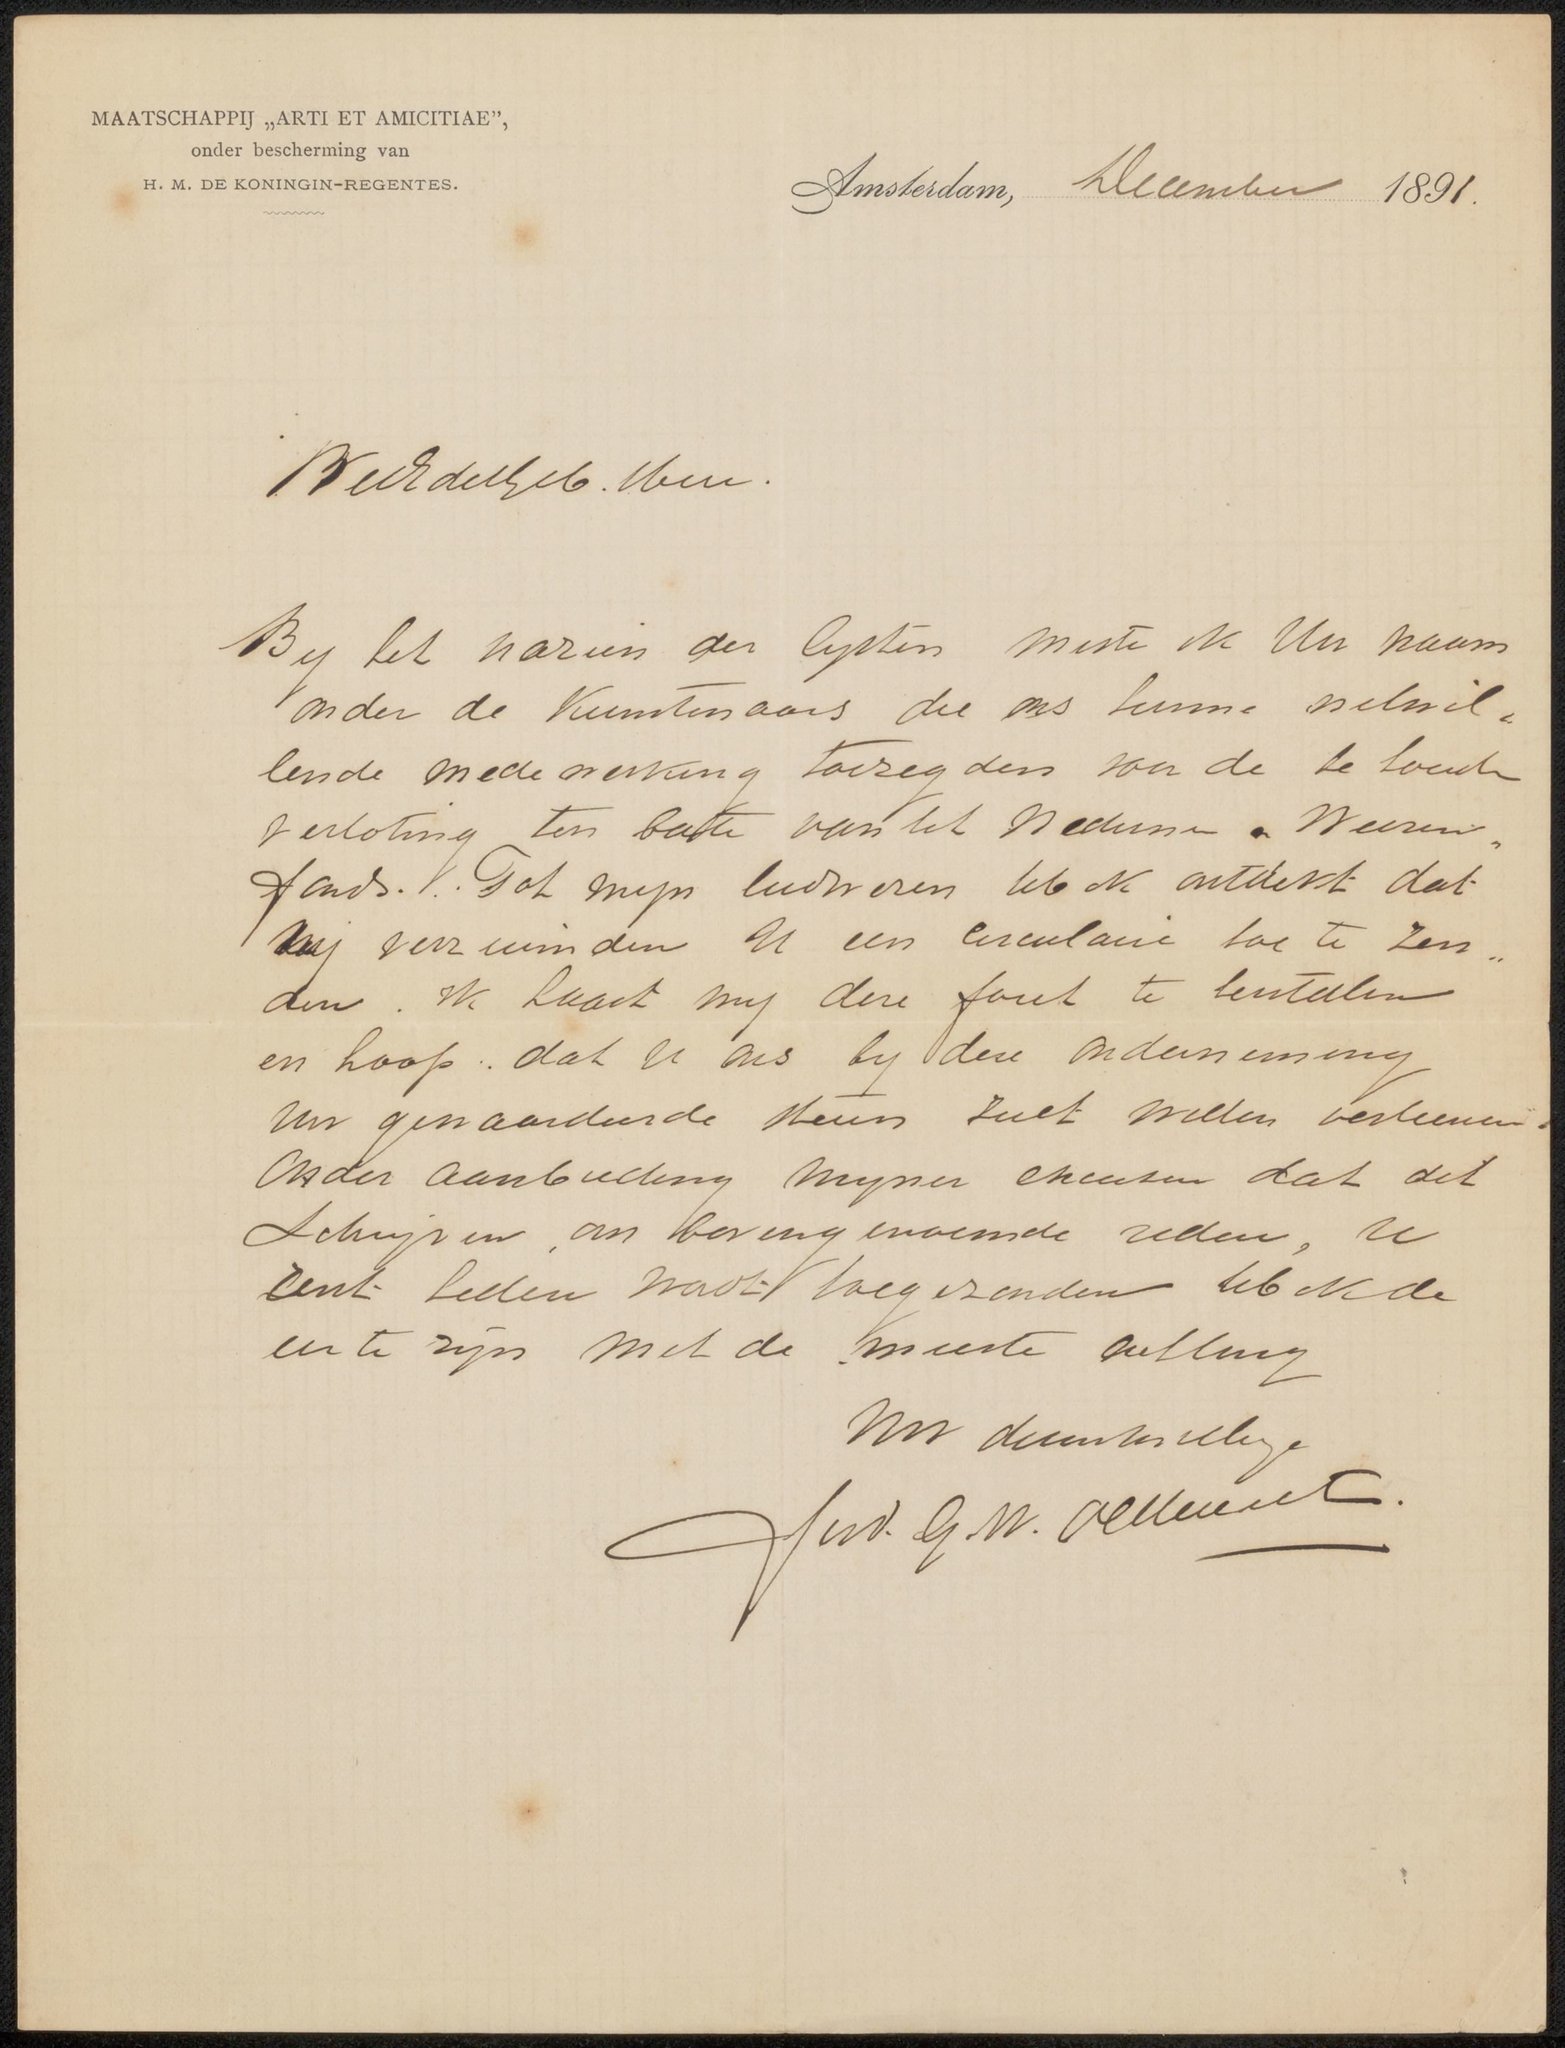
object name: letter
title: Brief aan Philip Zilcken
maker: ferdinand oldewelt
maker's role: draughtsman, print maker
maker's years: 1857-1935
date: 1891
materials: ink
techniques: pen, printing, writing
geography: amsterdam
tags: the hague, painter, draughtsman, philip zilcken, contrast between important and unimportant people; the inferior before the superior, the weak before the mighty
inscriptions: watermark, collector's mark: ‘RPK’